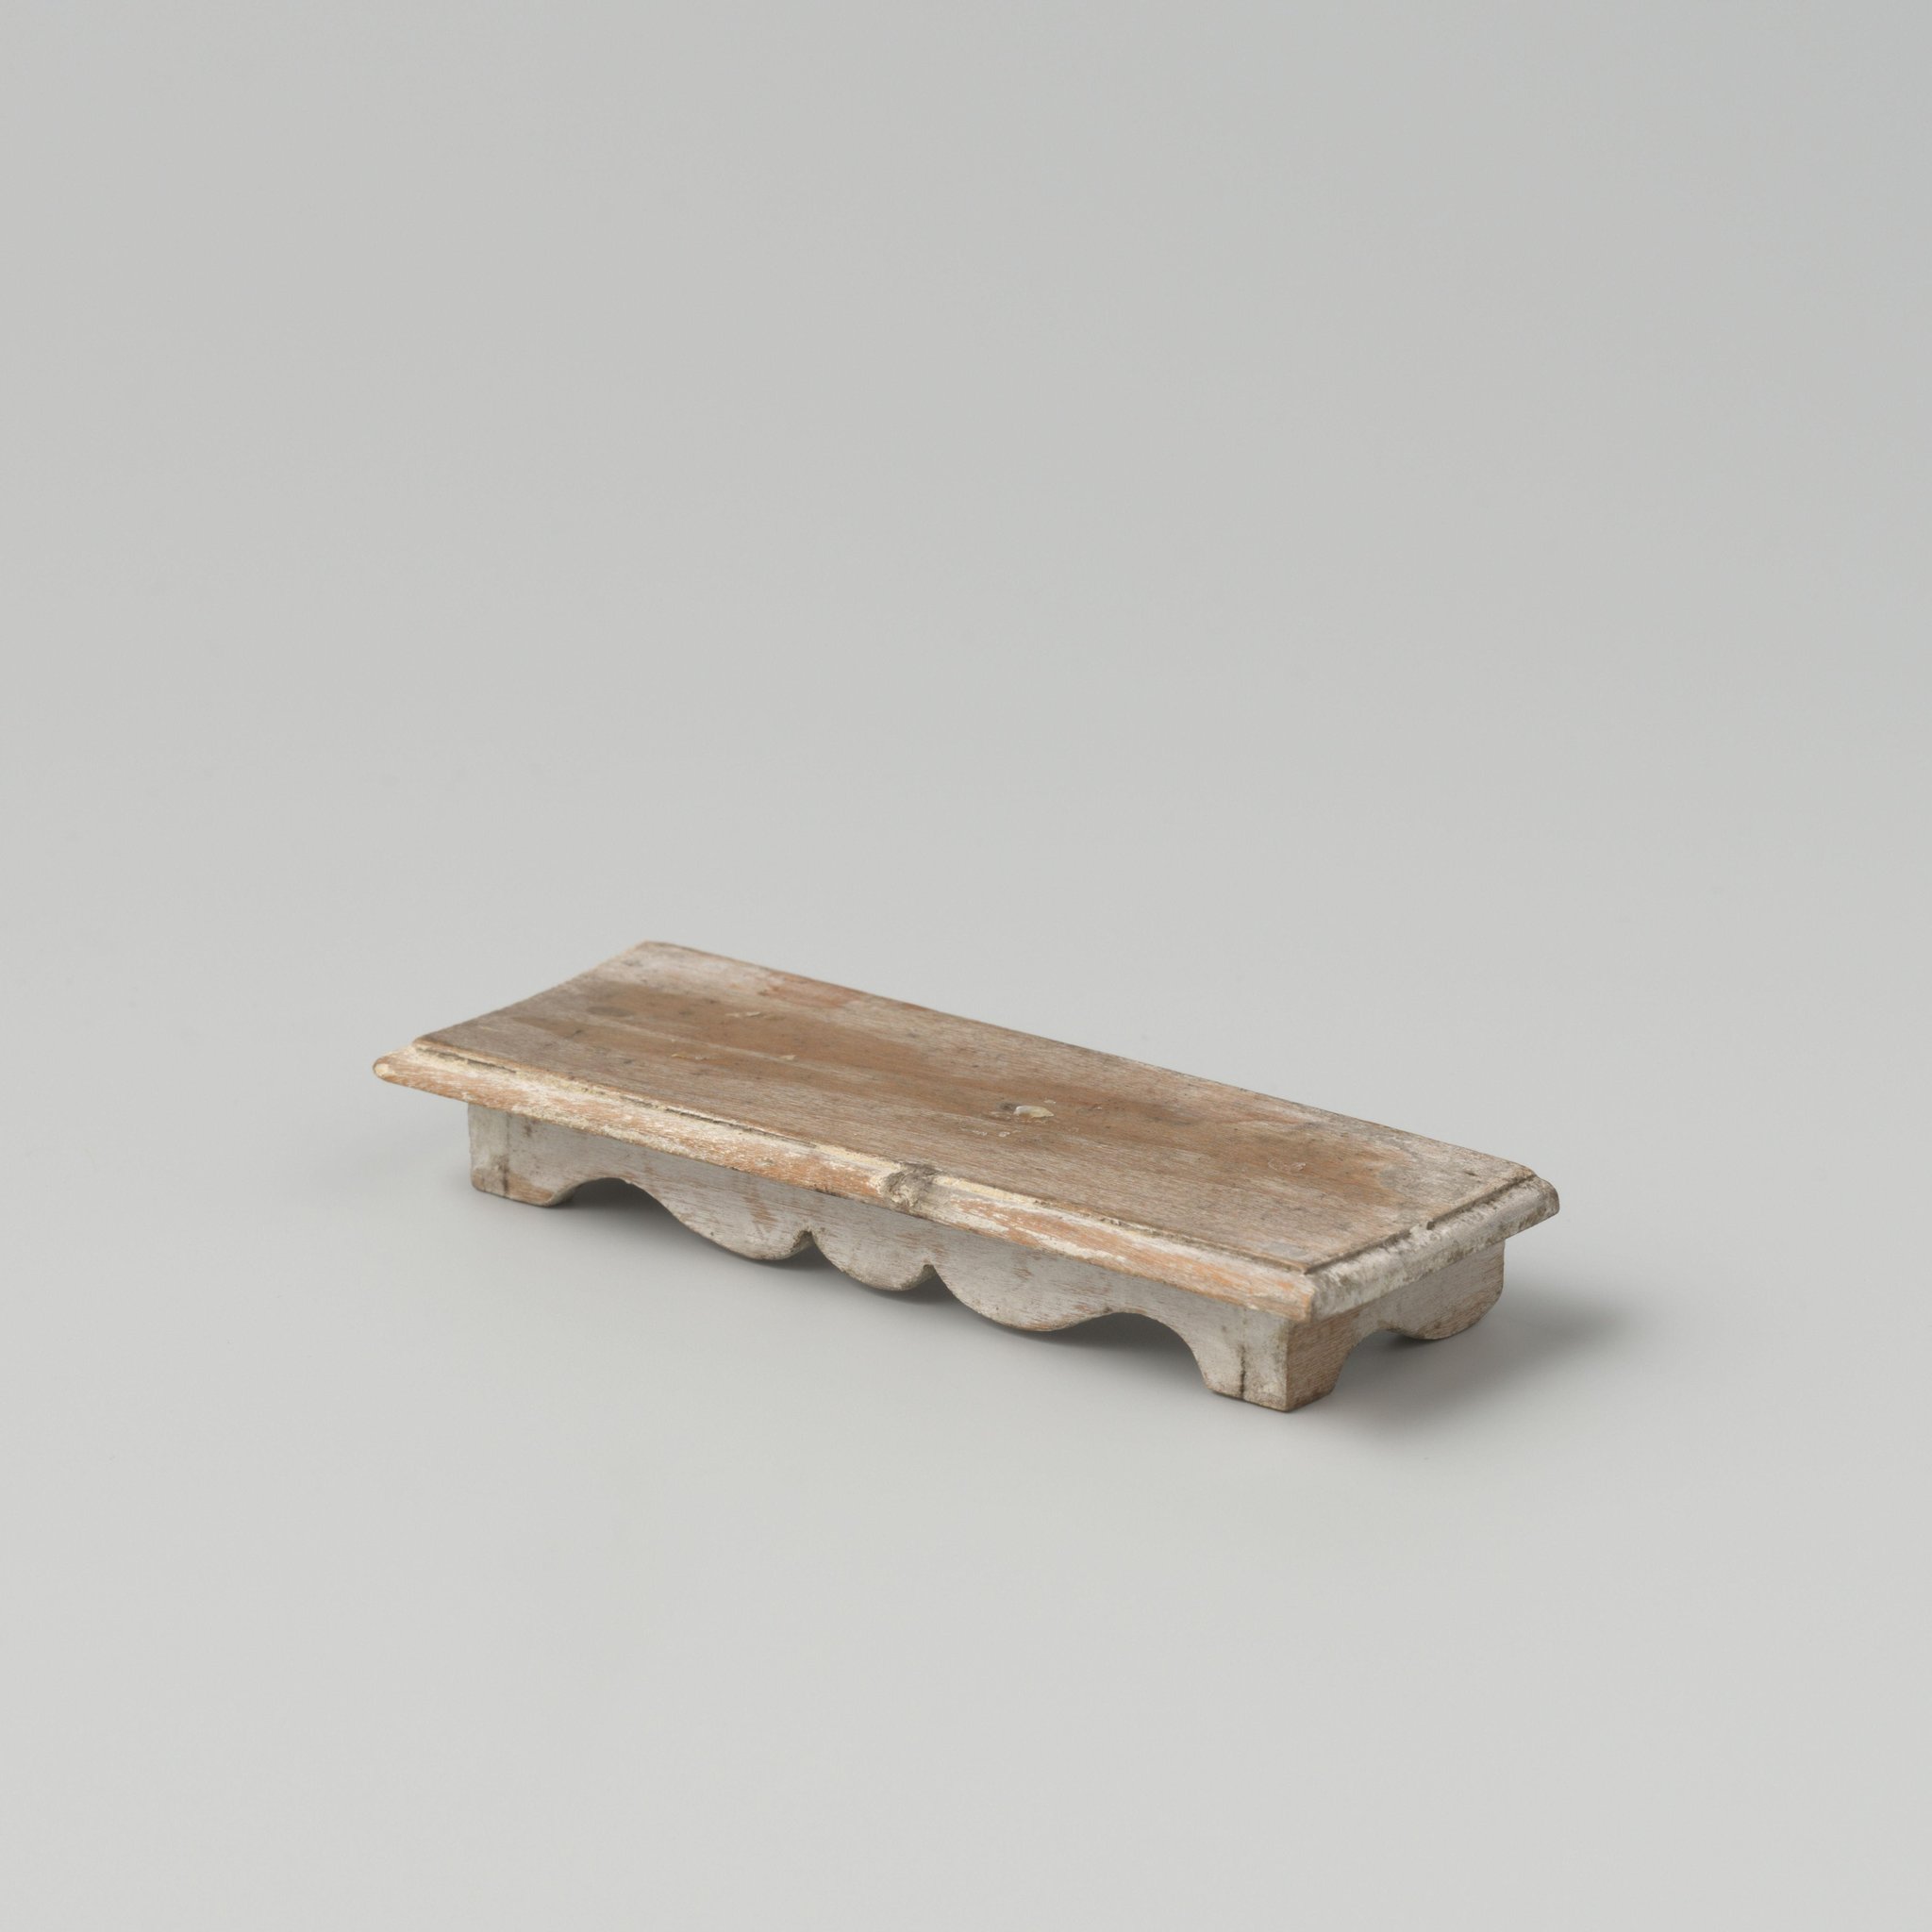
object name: miniature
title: Vlonder of laagbankje van een wit gesausd withoutsoort; bestaande uit een plank, aan 3 zijden met halfrond profiel, rustend op 3 plankjes met accolade vormige uitsnijdingen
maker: Anonymous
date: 1690-1710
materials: wood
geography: amsterdam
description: Vlonder of laag bankje vervaardigd van een wit gesausd withoutsoort; bestaande uit een plank, aan drie zijden met halfrond profiel, rustend op drie plankjes met accolade vormige uitsnijdingen.